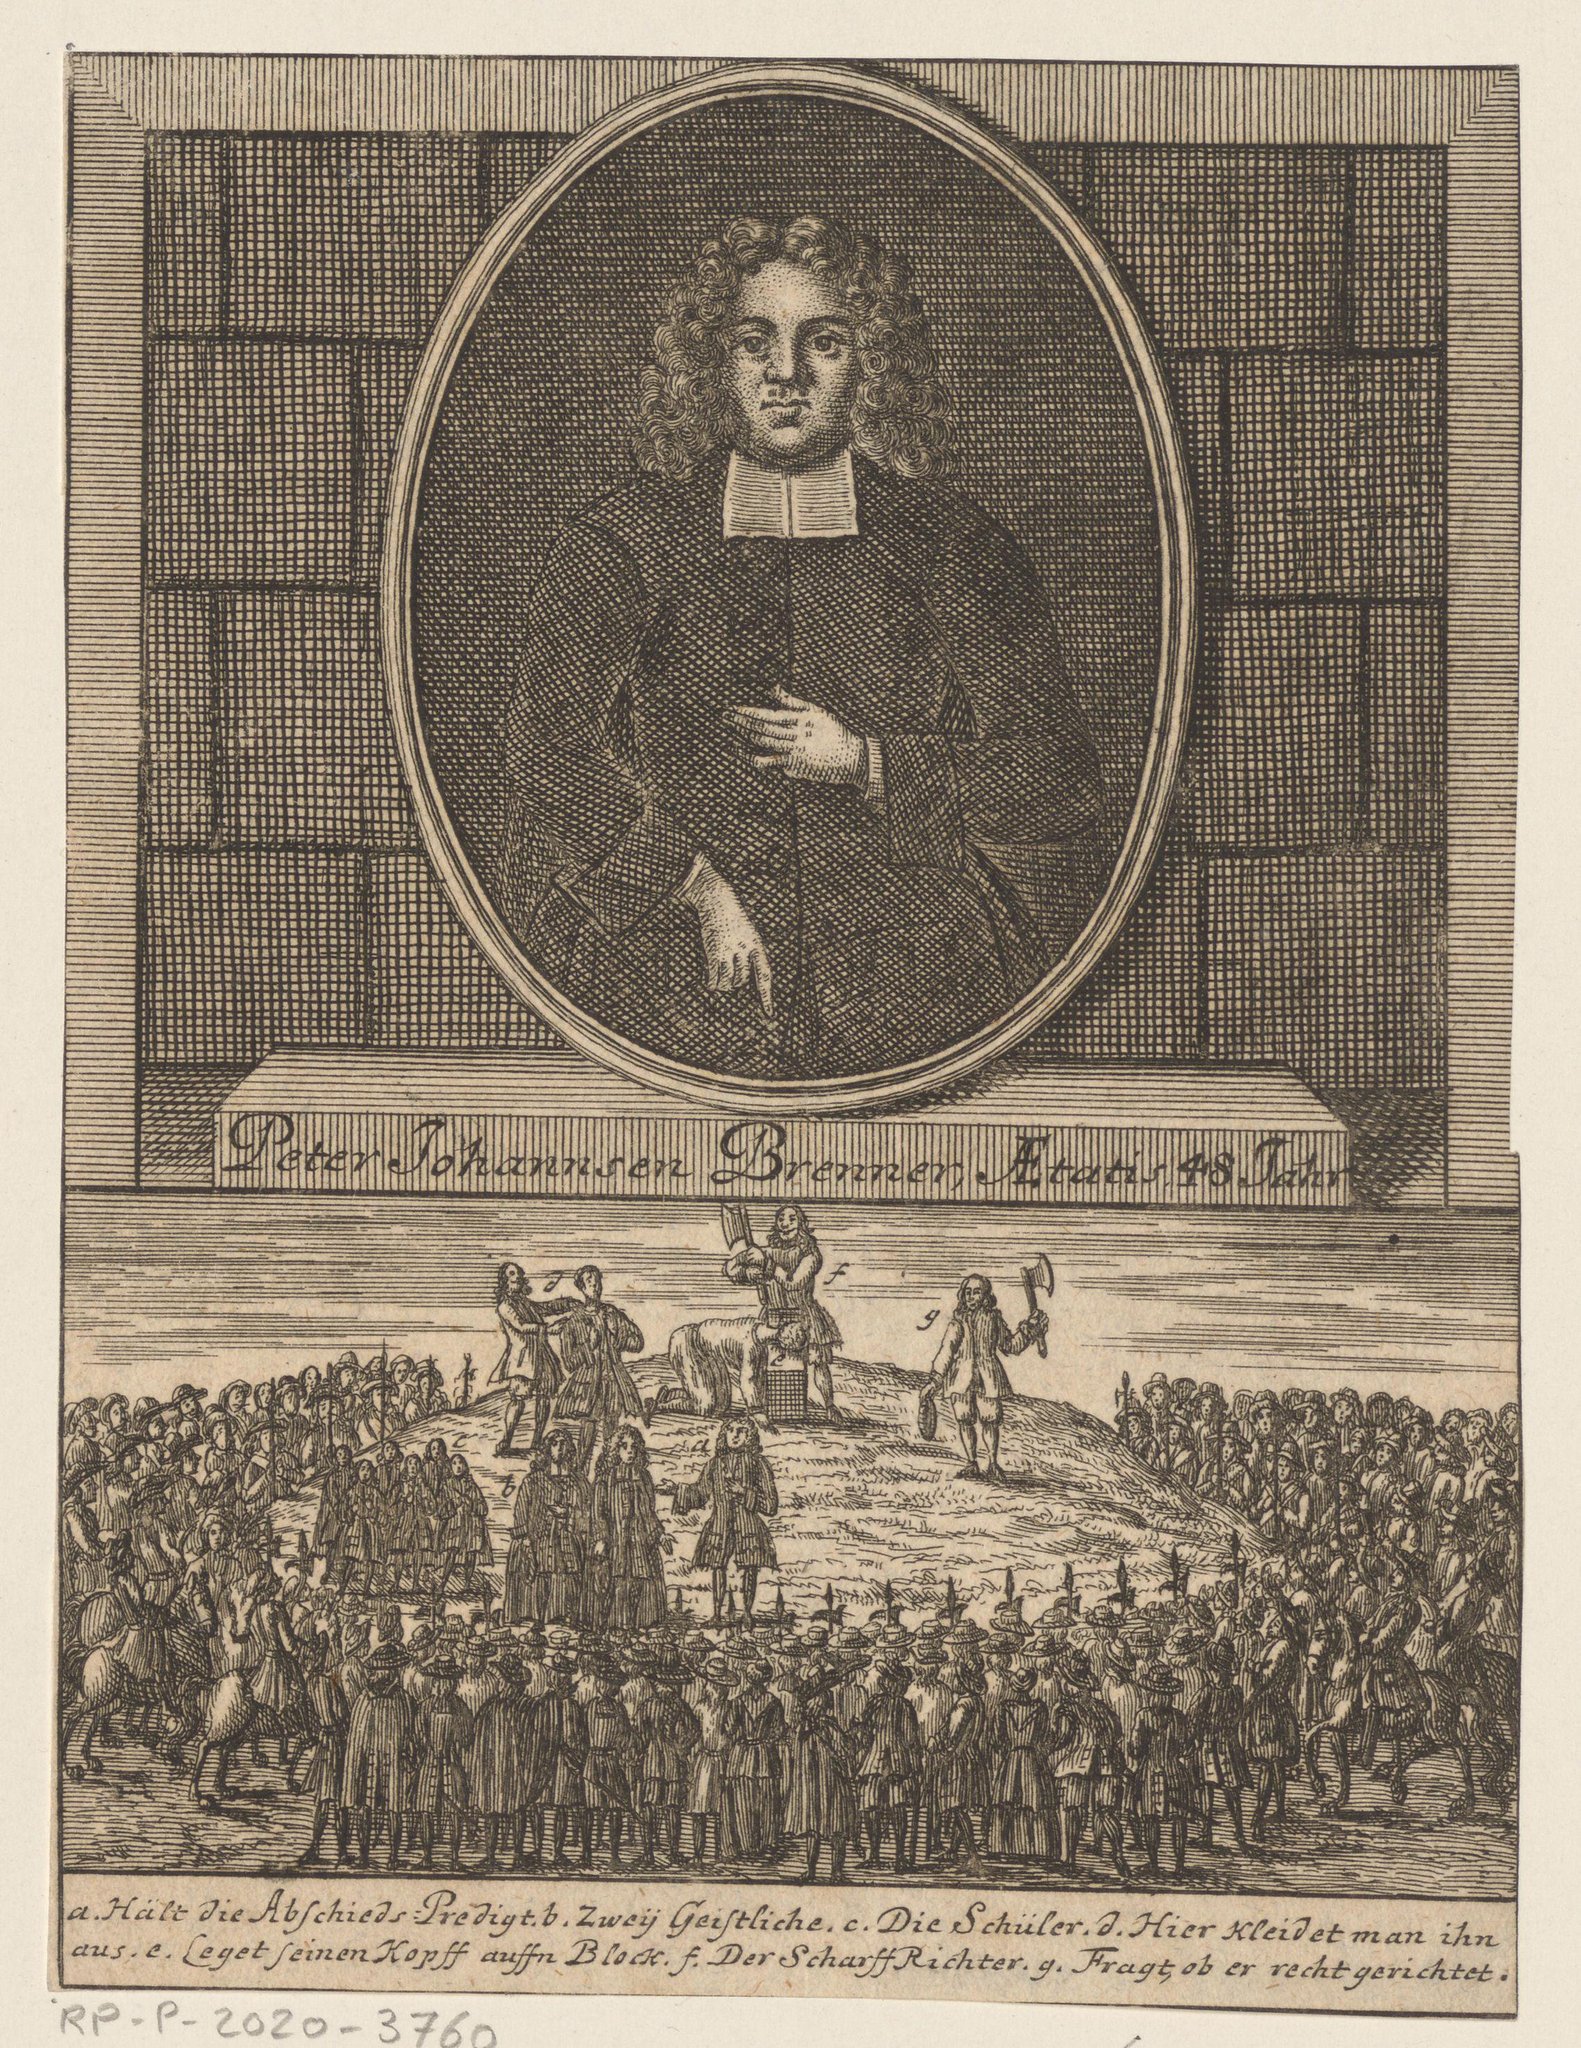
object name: print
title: Portret van Peter Johansson Brenner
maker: Anonymous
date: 1720-1749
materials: paper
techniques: engraving, etching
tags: historical persons, violent death by beheading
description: Met onderaan de onthoofding van de geportretteerde afgebeeld.